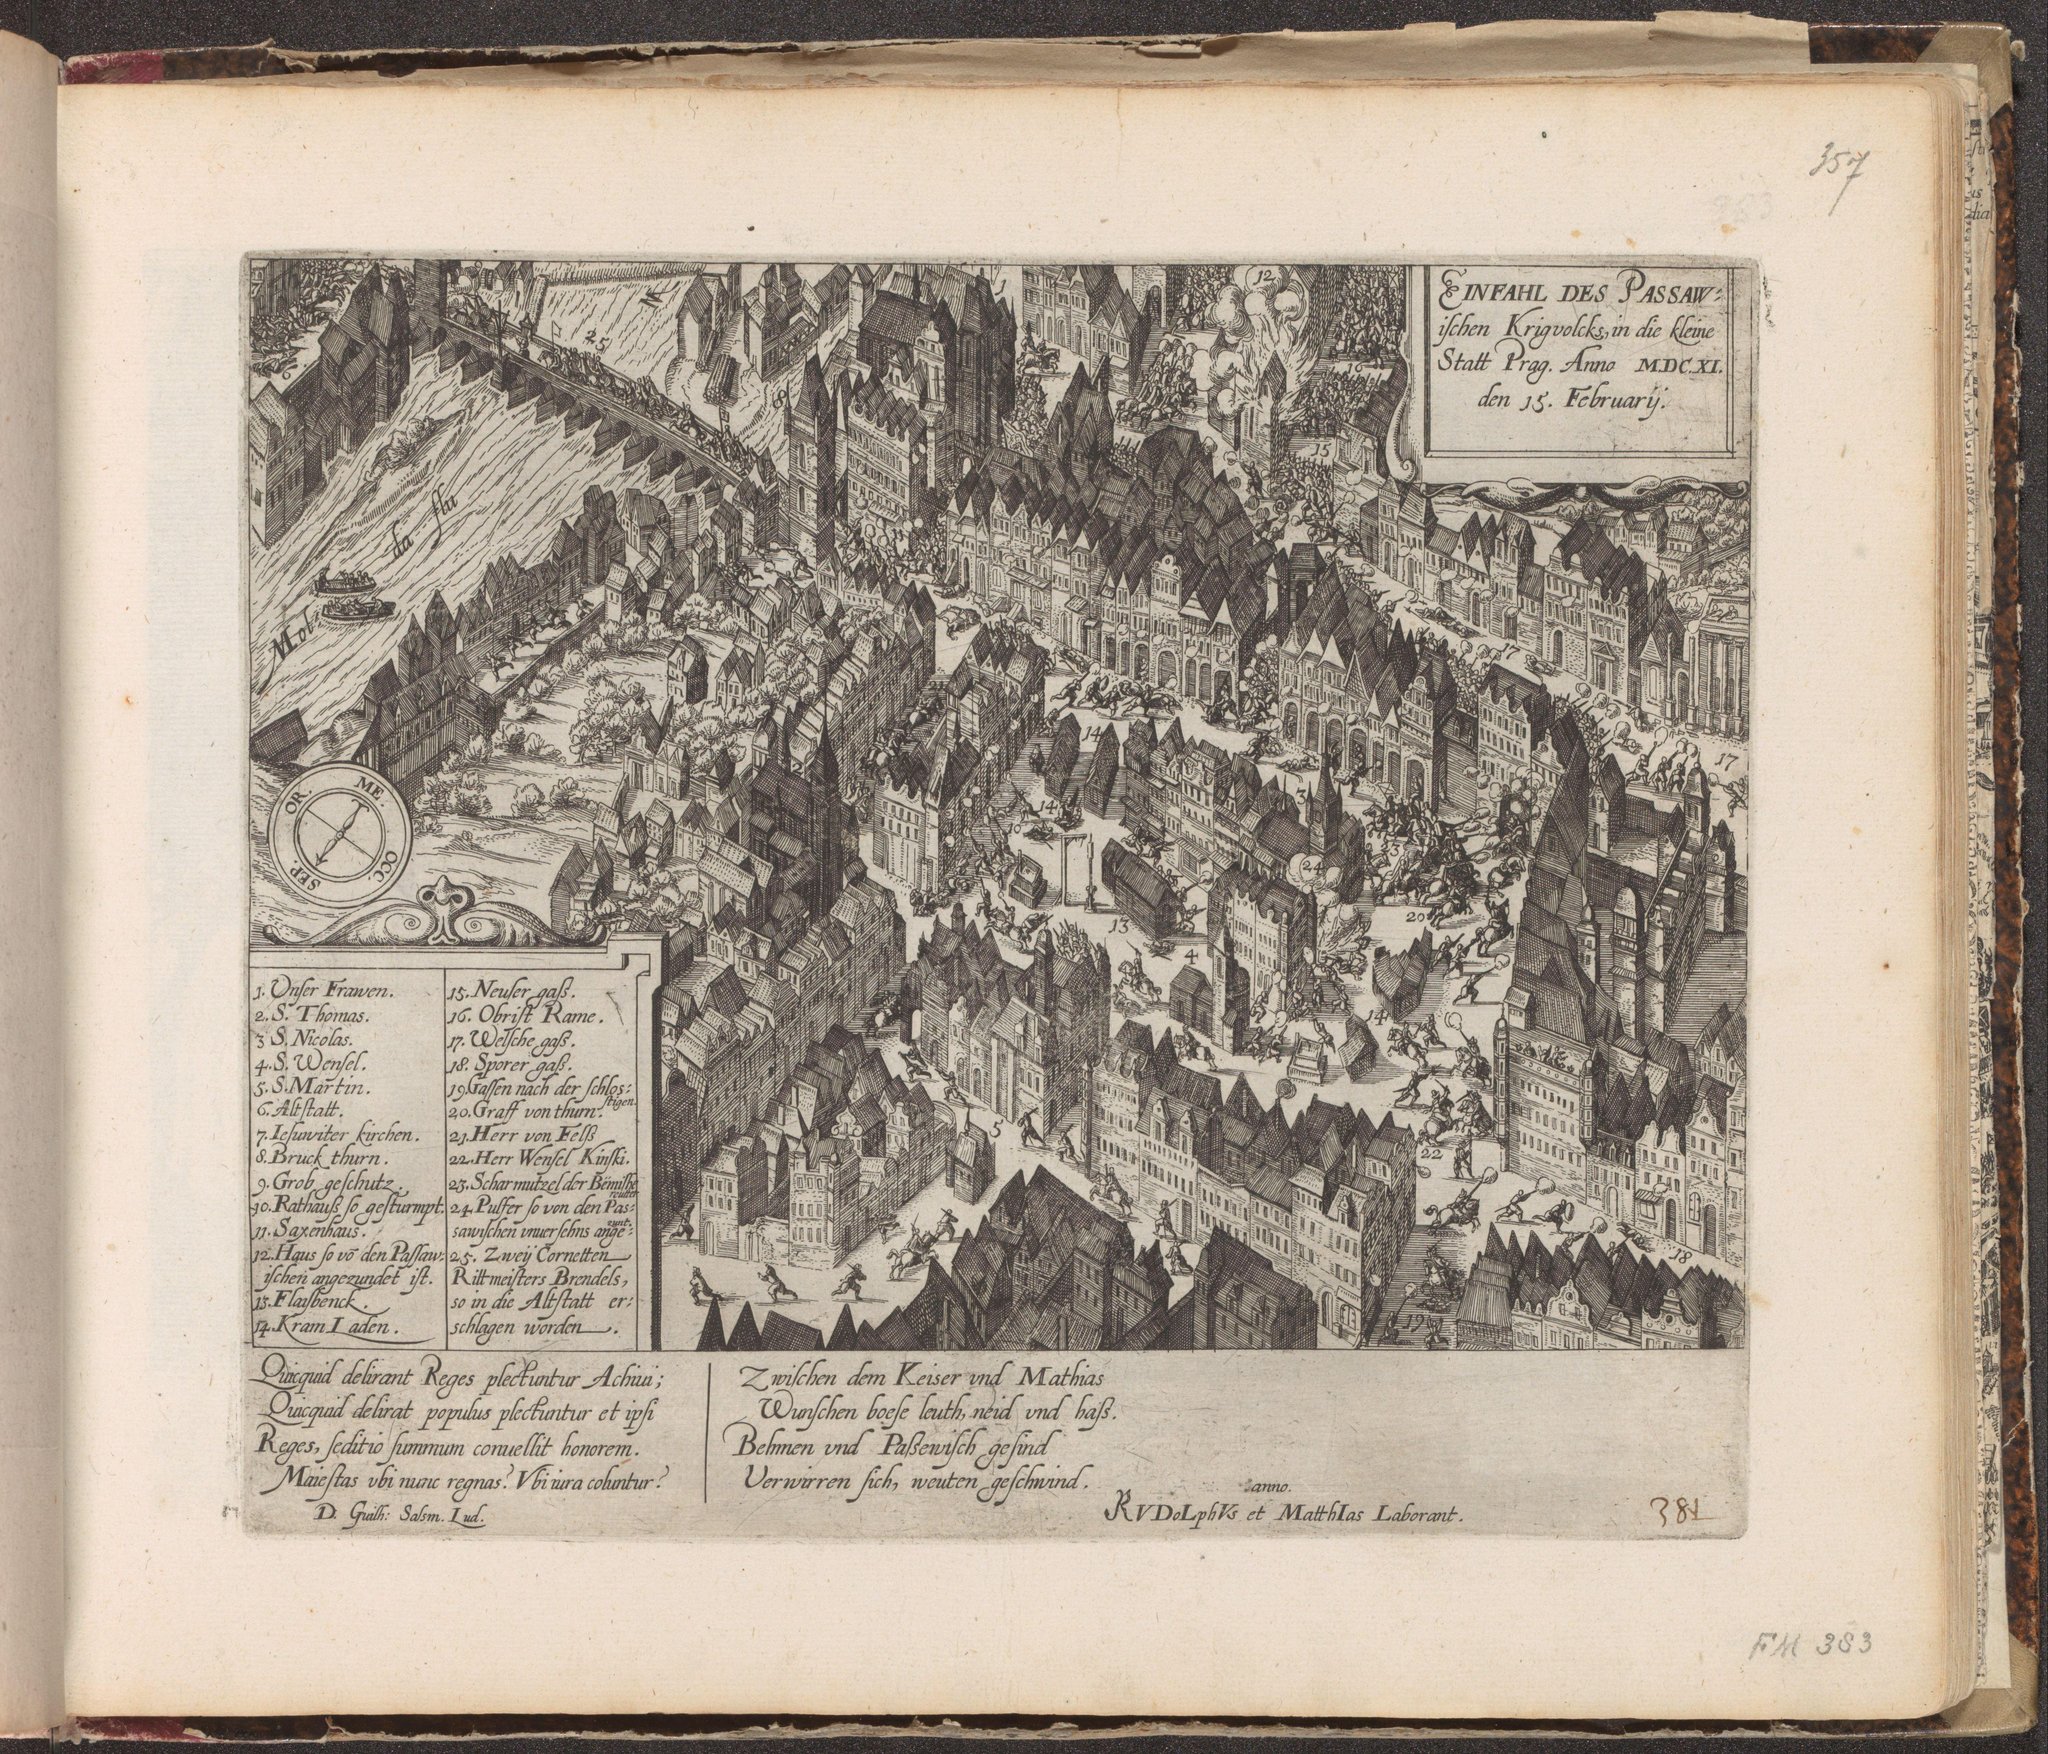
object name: album leaf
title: Inval in Praag, 1611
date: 1611-1613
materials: paper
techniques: etching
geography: cologne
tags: battle, fighting in general, prague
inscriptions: inscription: ‘381’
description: Inval van het Passause leger in Praag, 15 februari 1611. Met onderschrift van 4 regels in het Latijn en 4 regels in het Duits. Linksonder een cartouche met de legenda 1-25. Rechtsonder met pen genummerd: 381. De prent maakt deel uit van een album.